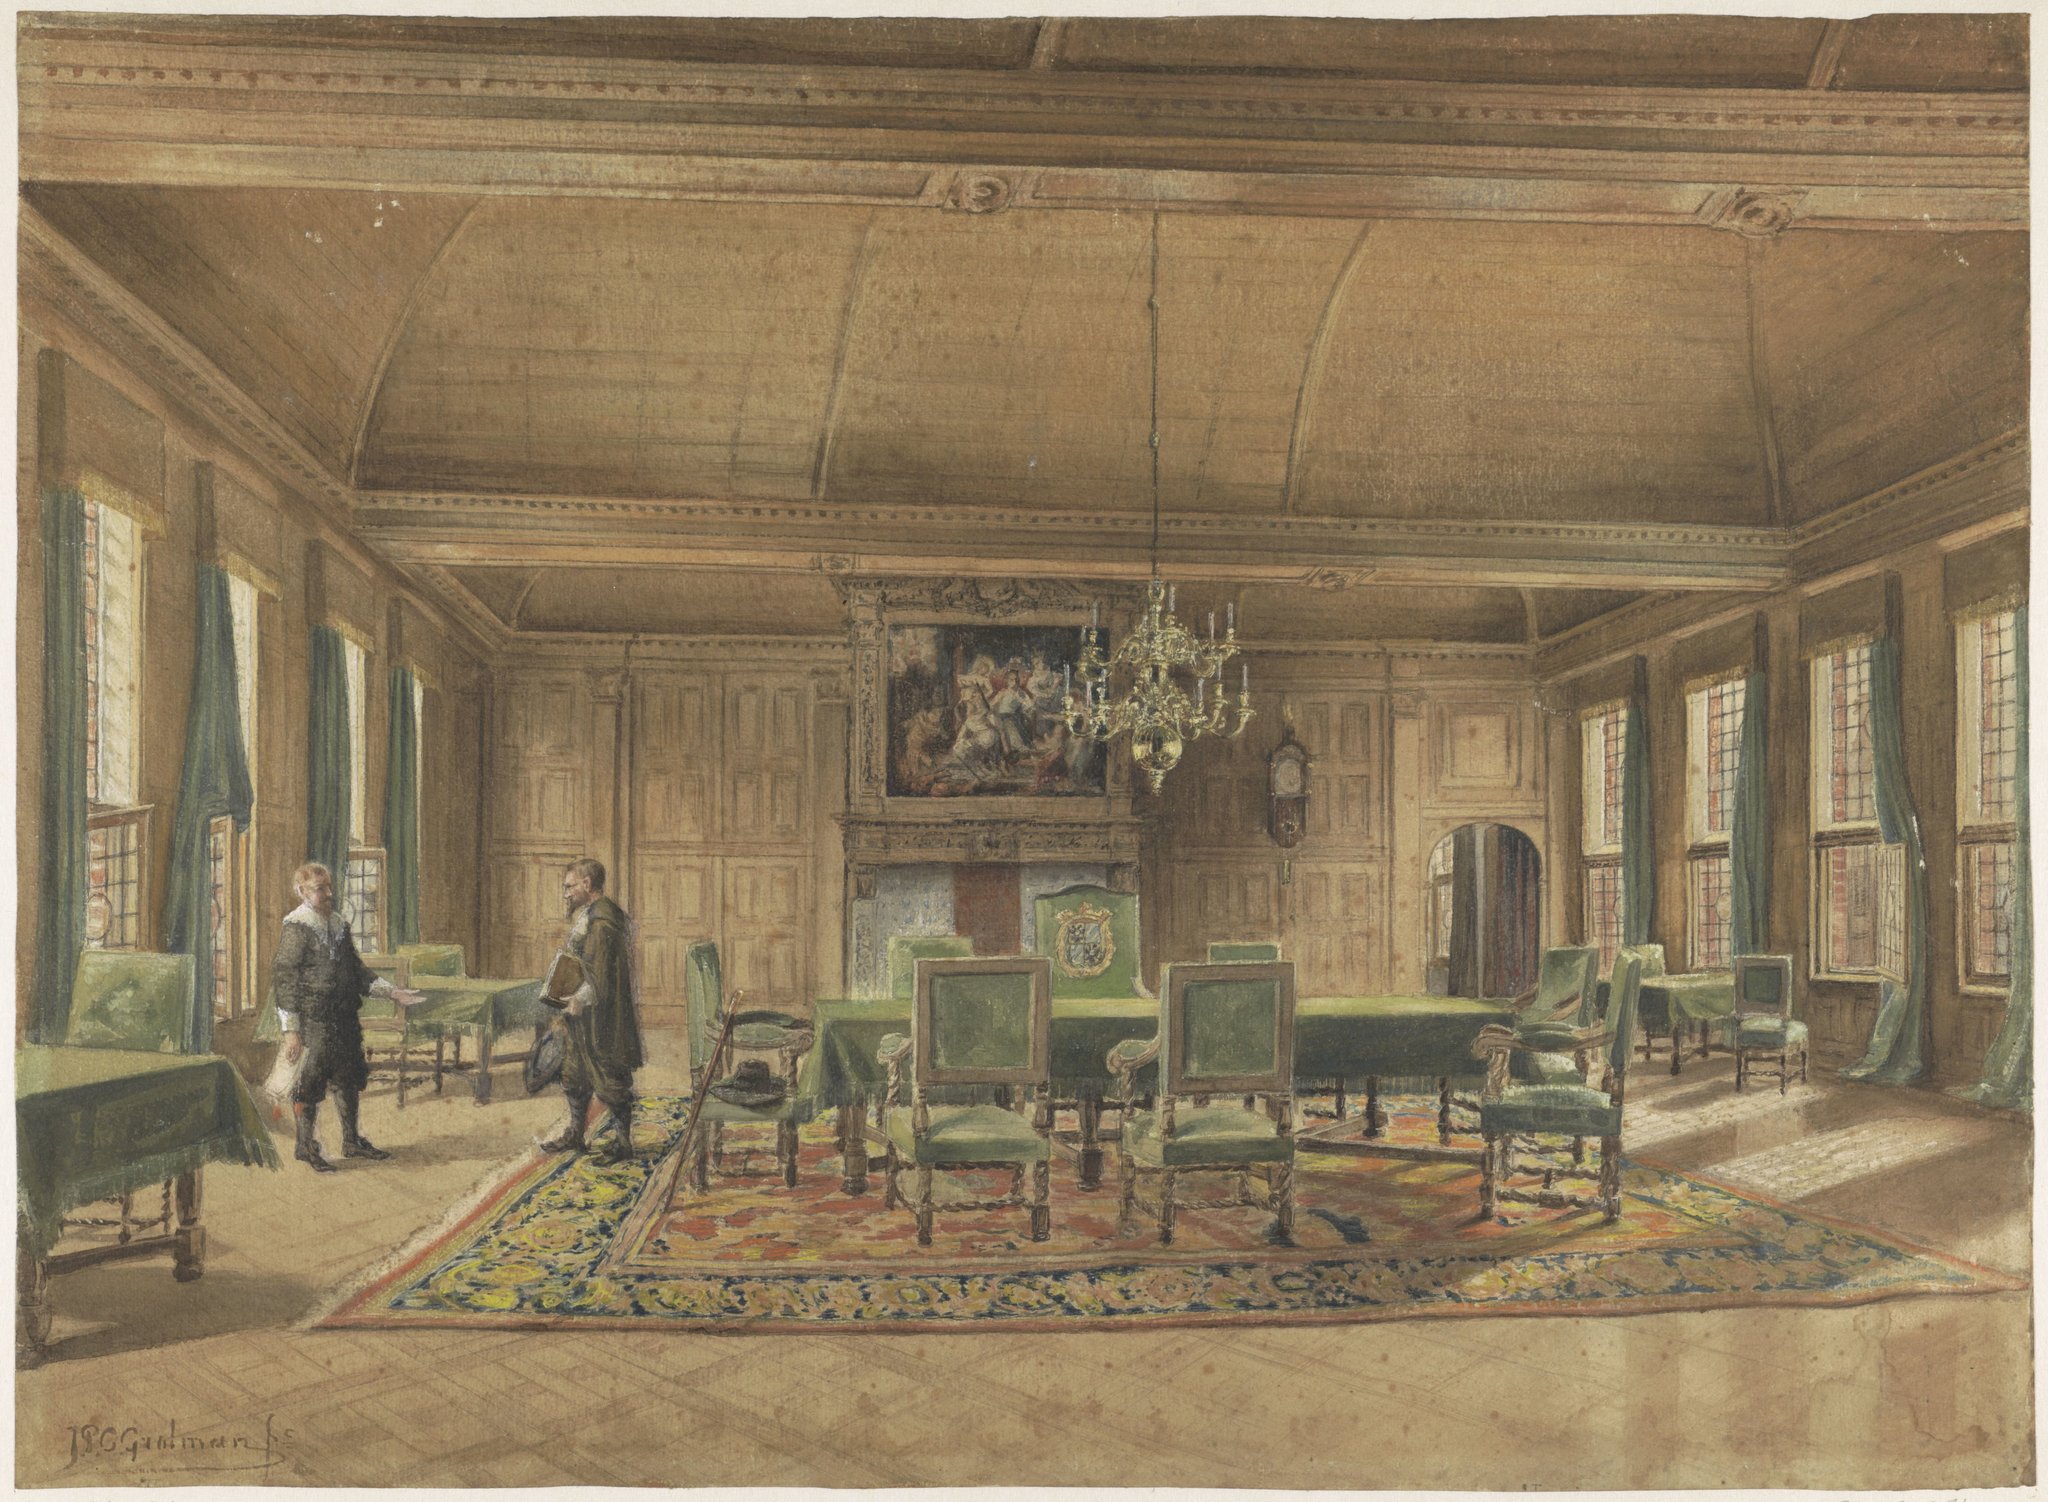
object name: drawing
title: De Gedeputeerdenraad in het Provinciehuis te Groningen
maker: johan paul constantinus grolman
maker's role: draughtsman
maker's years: 1841-1927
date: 1851-1927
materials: paper, watercolor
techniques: brush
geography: groningen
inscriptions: signature: ‘J.P.C. Grolman fc.’, annotation: ‘Zaal in het Provinciehuis te Groningen / J.P.C. Grolman’